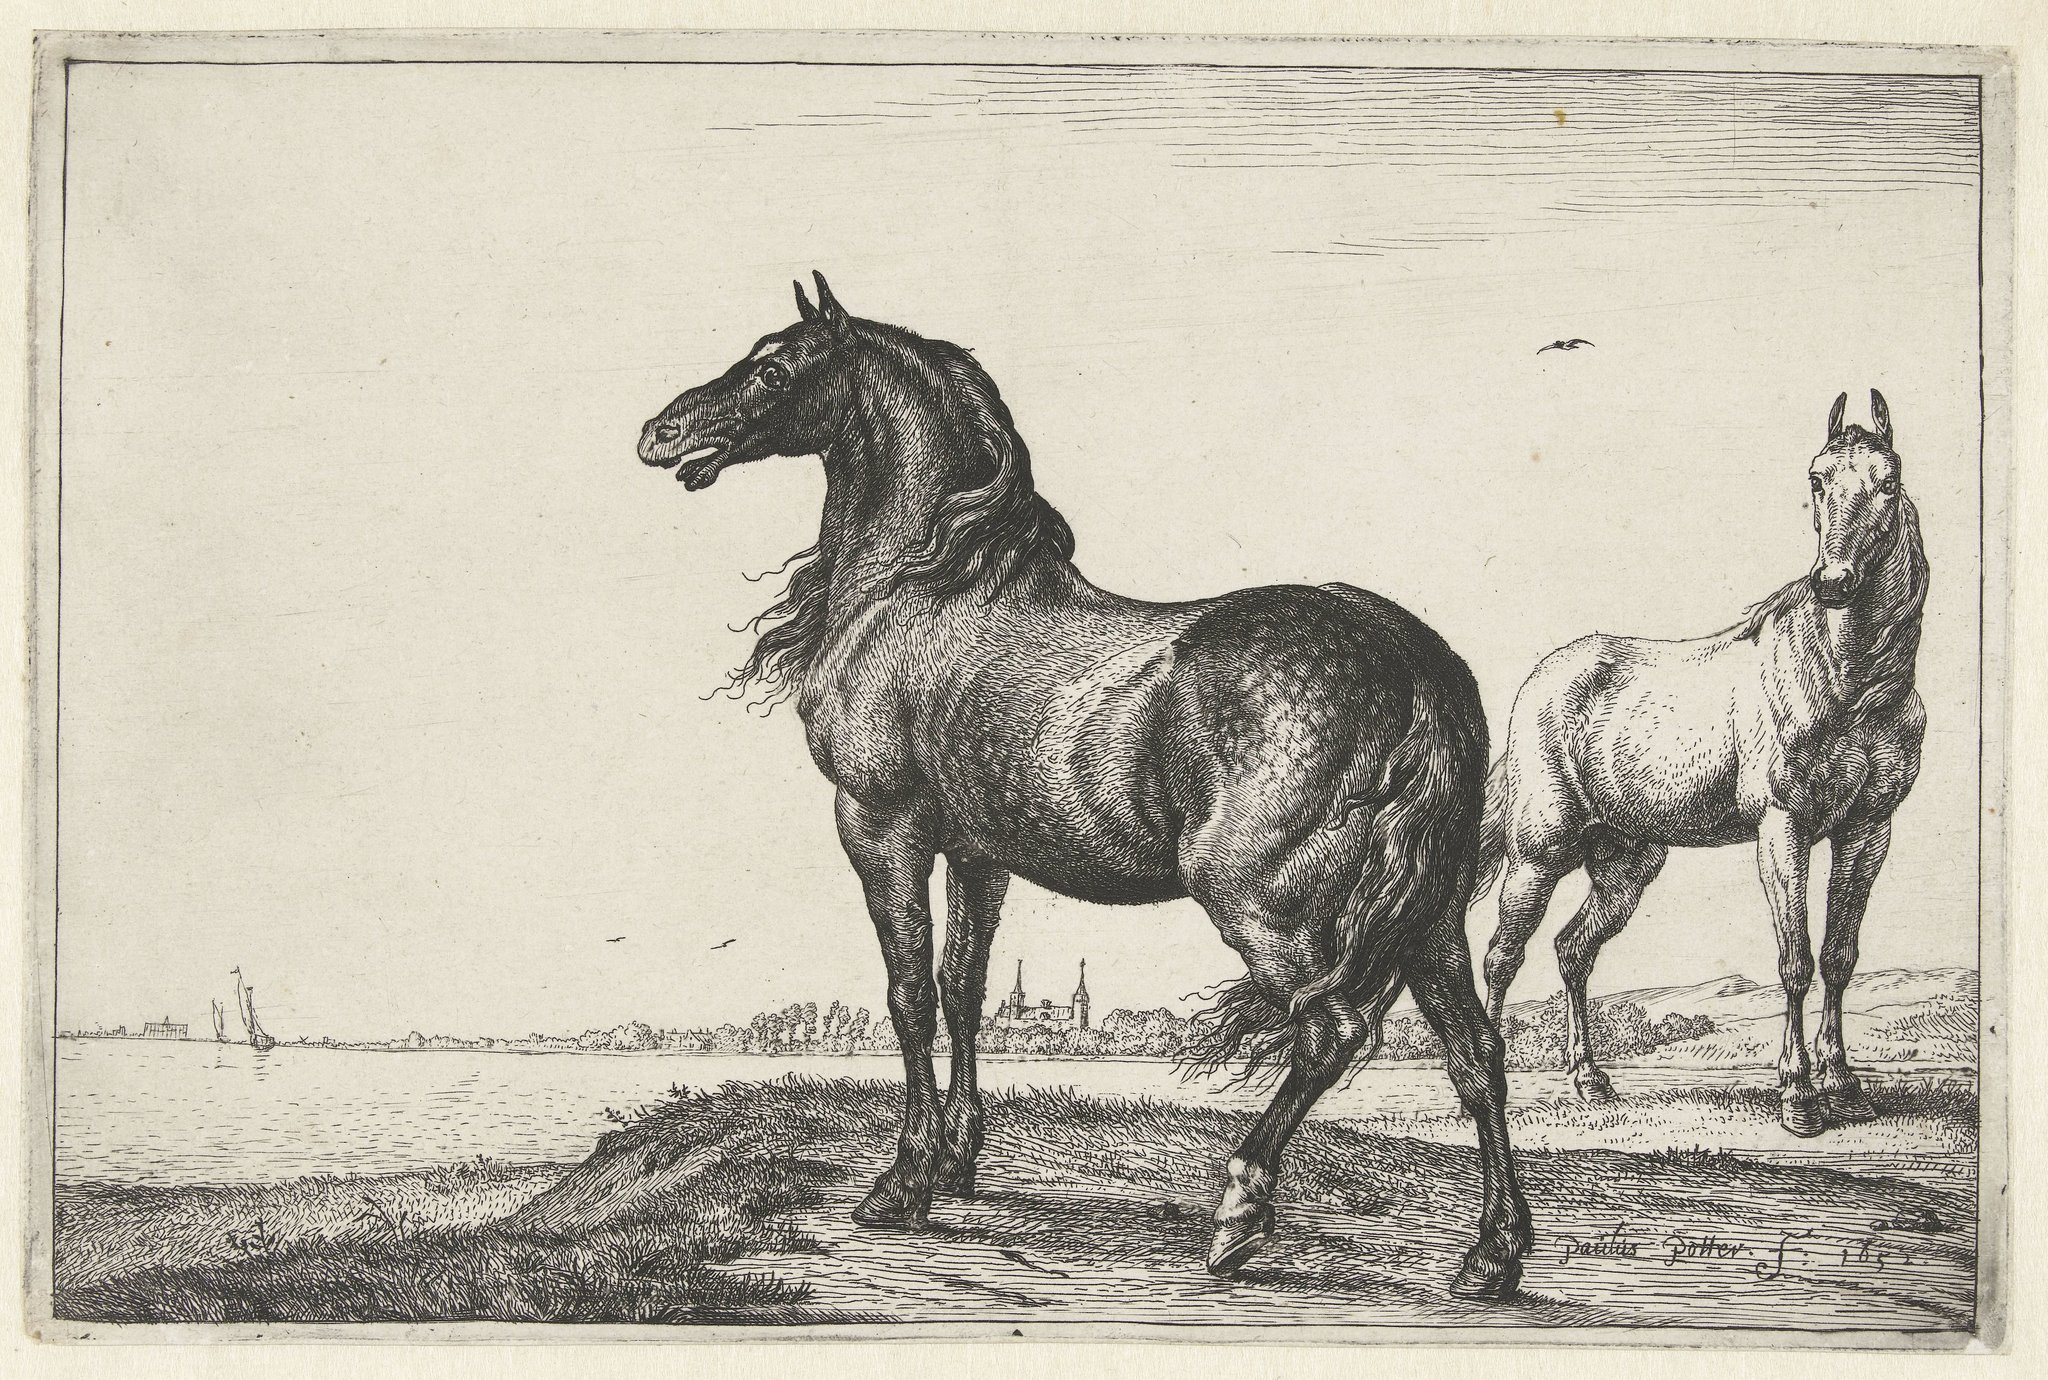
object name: print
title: Hinnikend paard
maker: paulus potter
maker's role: draughtsman, painter, print maker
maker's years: 1625-1654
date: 1652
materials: paper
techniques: etching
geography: netherlands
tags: animals (+ audible means of communication of animal(s): roaring, crying, singing, barking, mewing, neighing, chirping, etc.), horse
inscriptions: collector's mark: Lugt 240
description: Een zwart en een wit paard op de oever van een groot water. In de verte een stad.